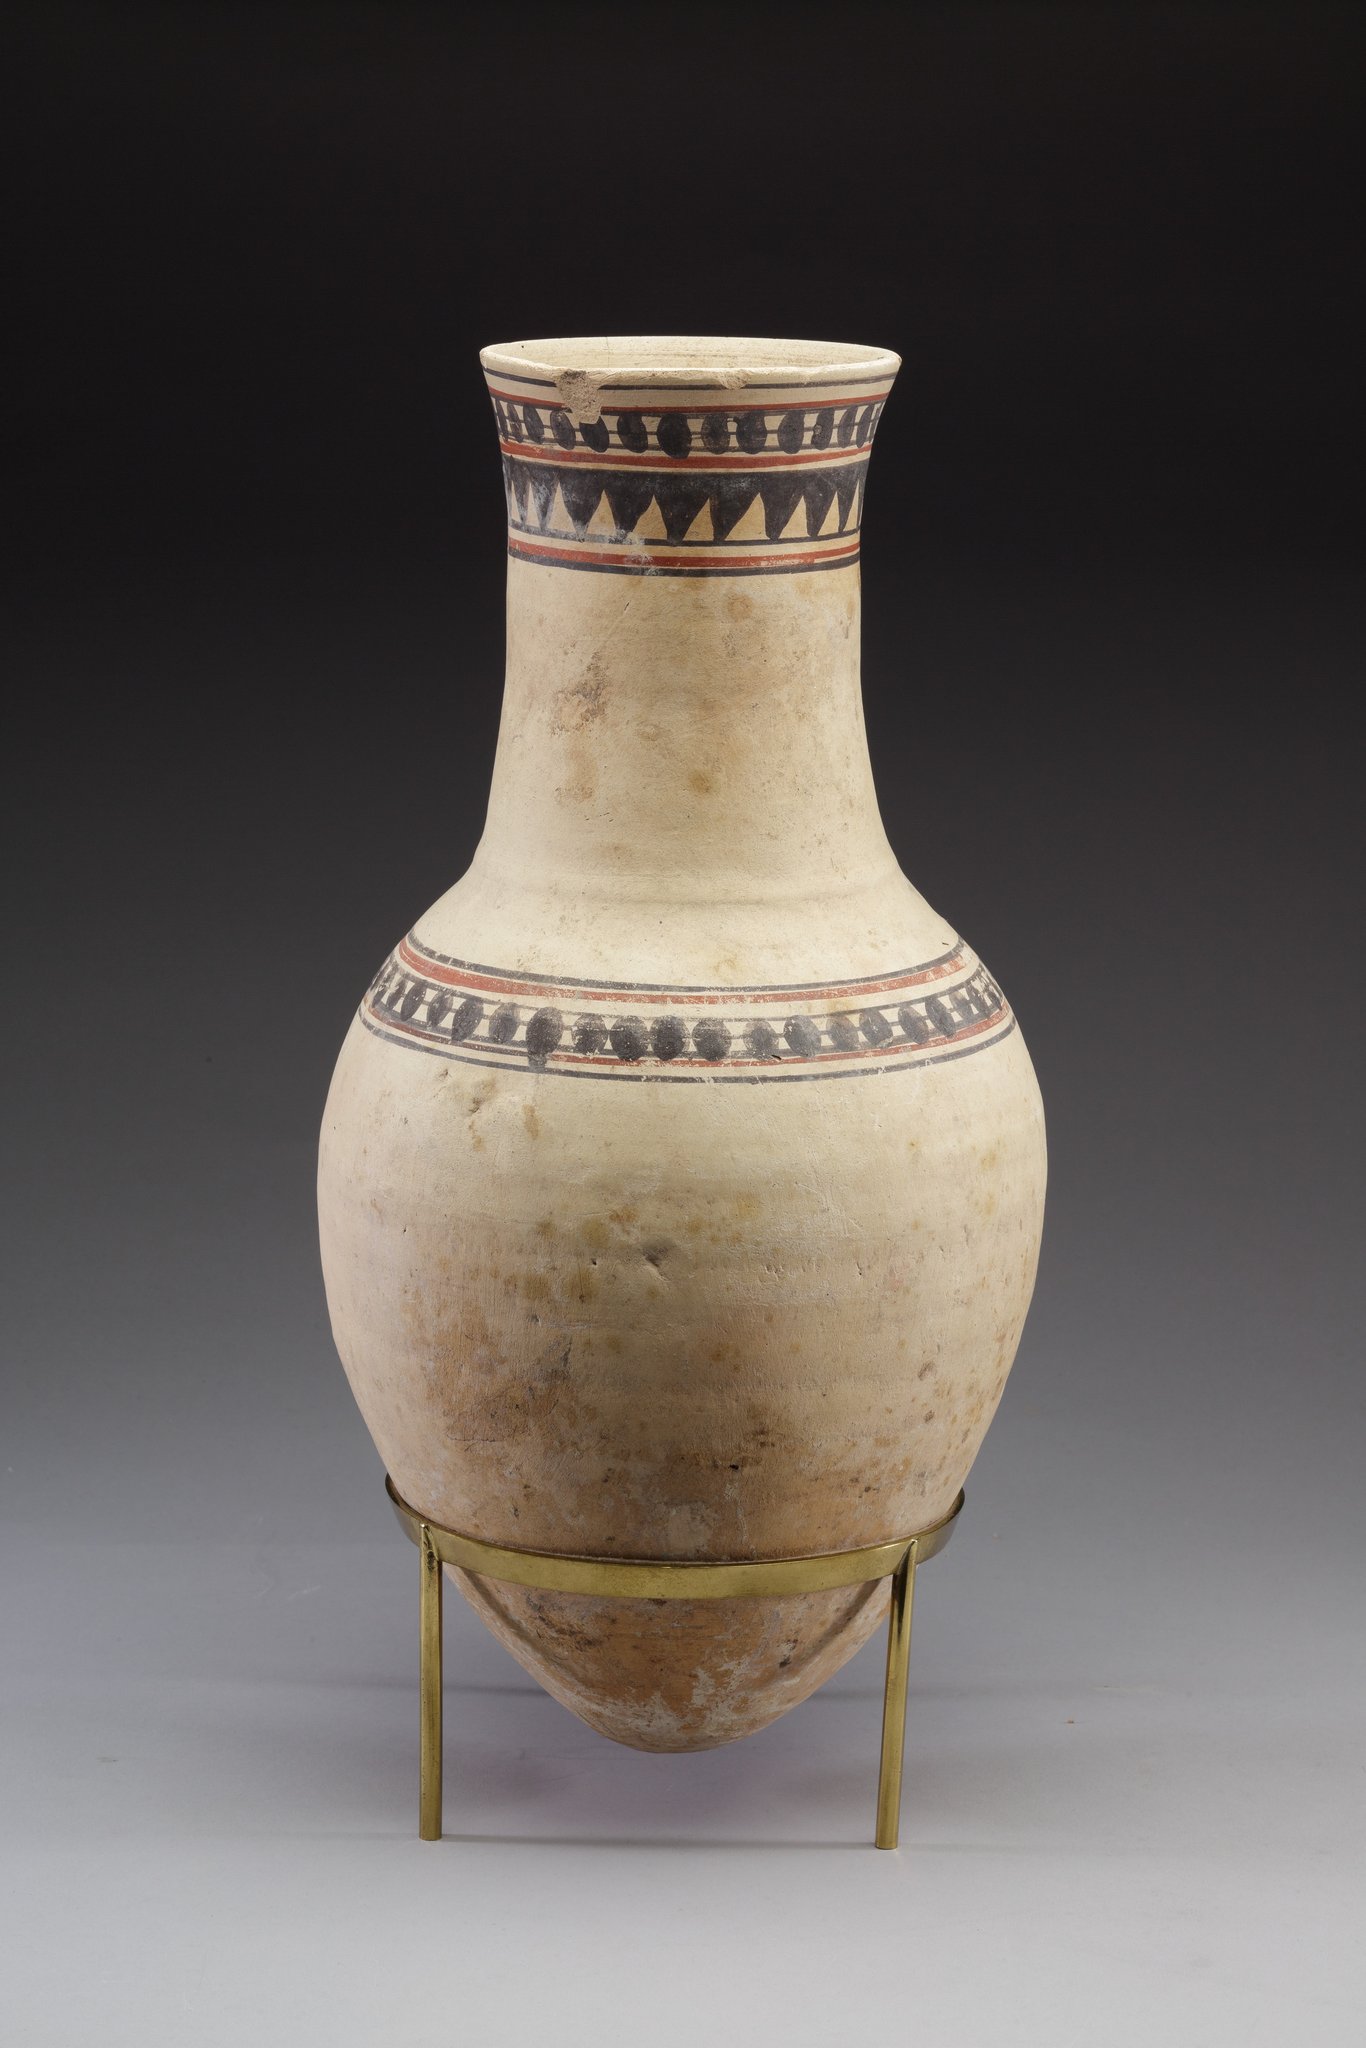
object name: jar, marl, white washamenhotep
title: Jar from the Burial of the Child Amenhotep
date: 1479-1458 BCE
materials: paint, pottery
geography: egypt